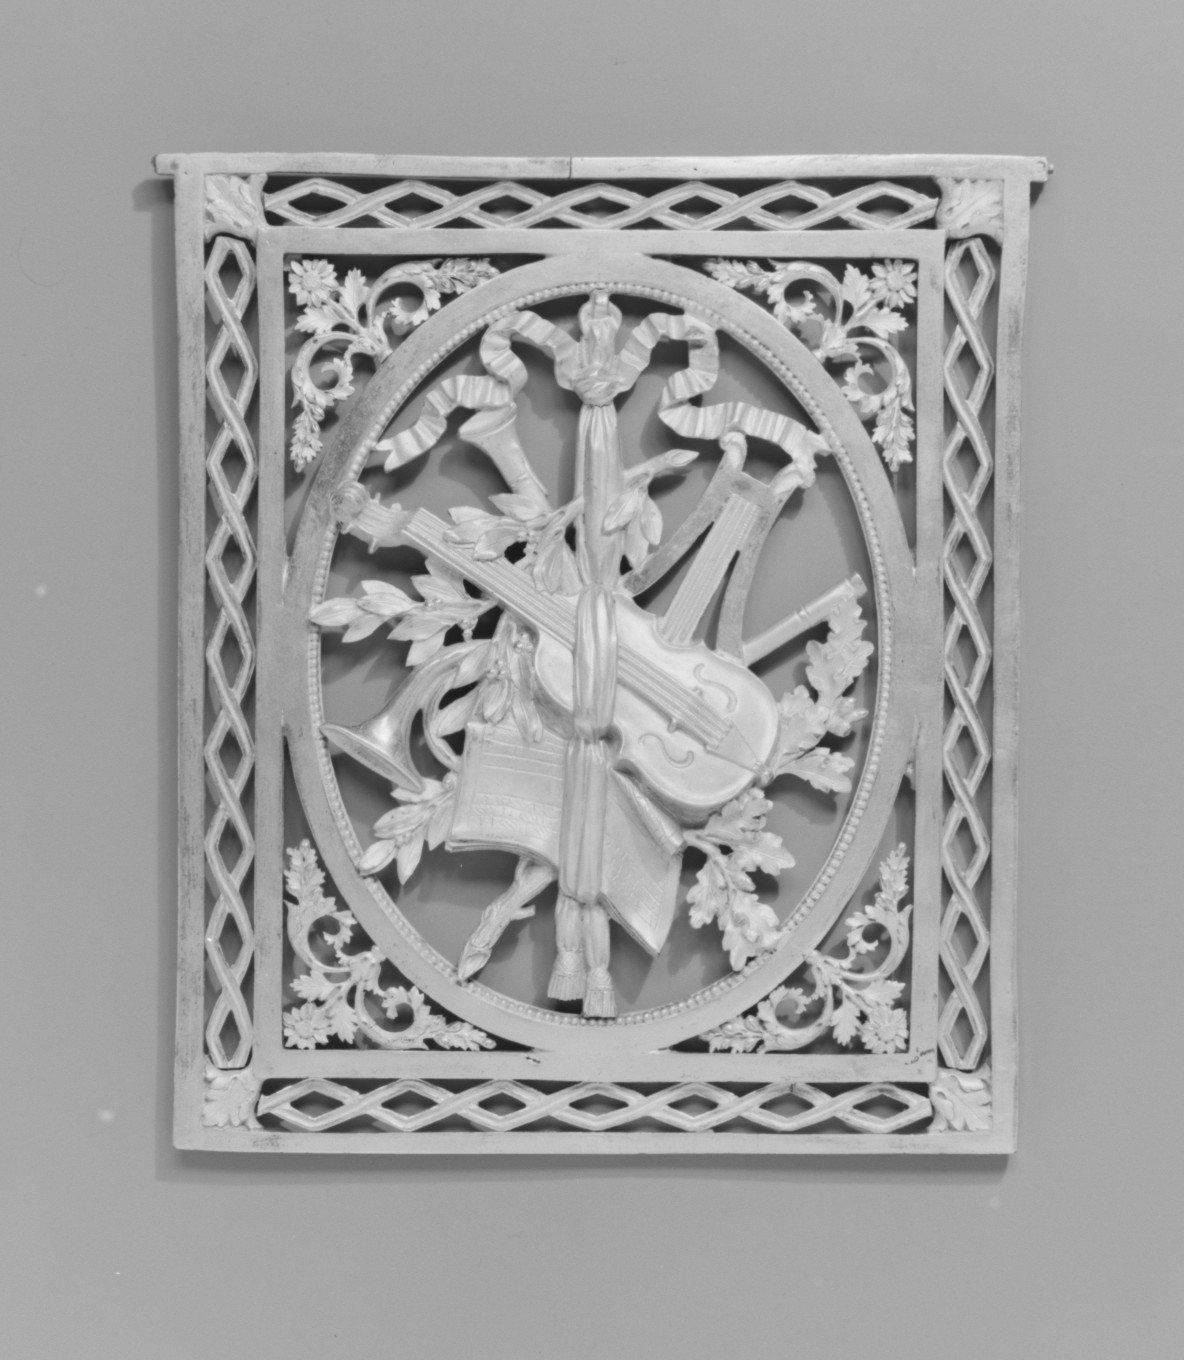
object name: panel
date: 1701-1800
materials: gilt bronze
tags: musical instruments,flowers